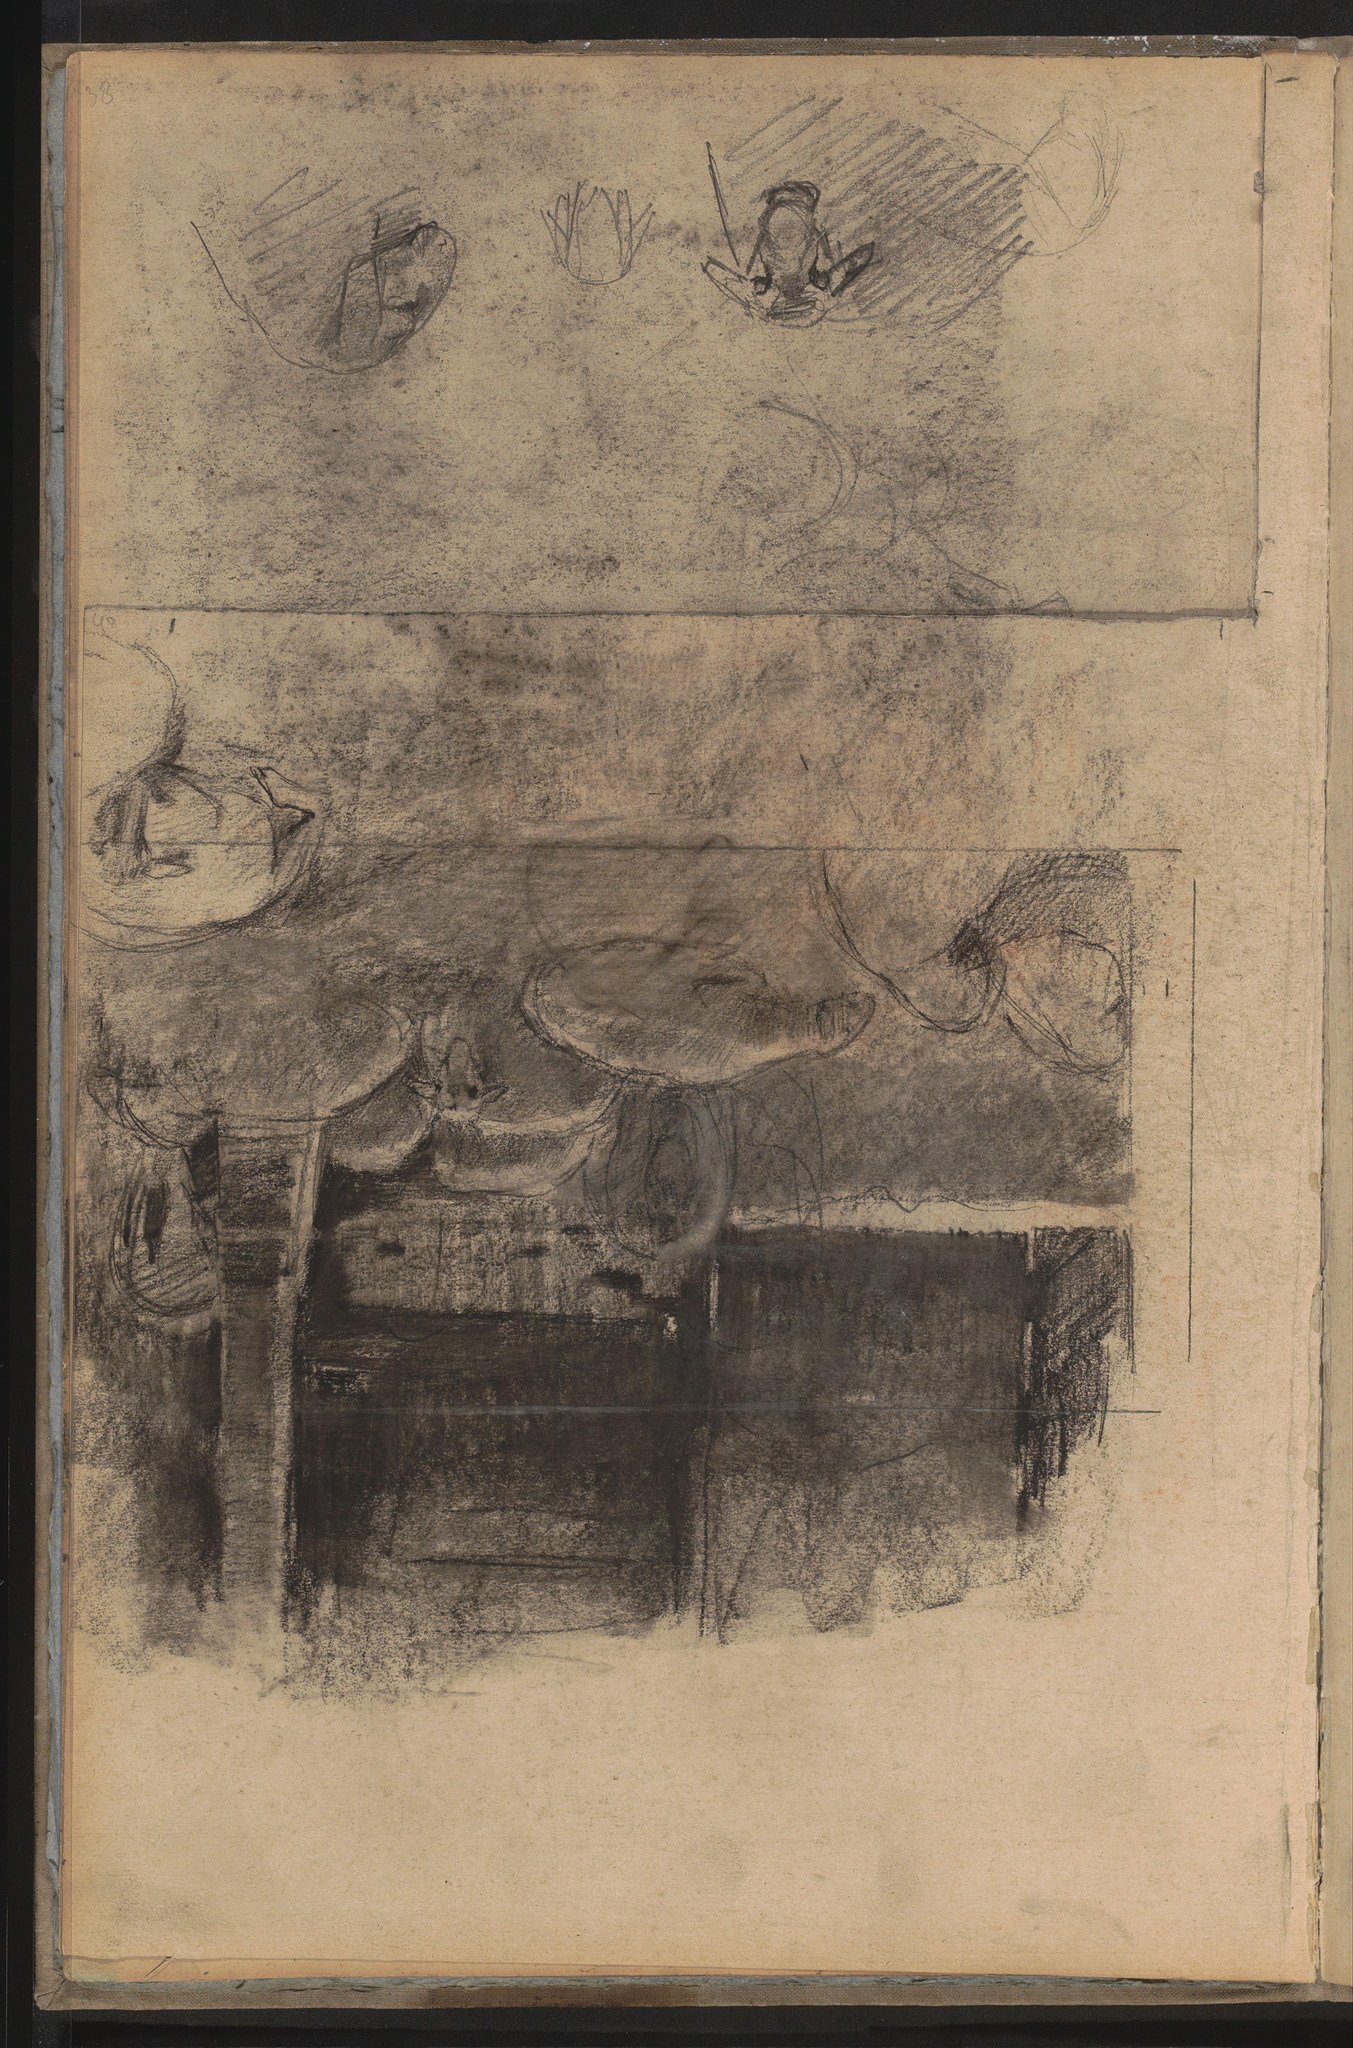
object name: sketchbook leaf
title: Schaapskooi met schapen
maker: willem witsen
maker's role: draughtsman, painter, print maker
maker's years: 1860-1923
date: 1884-1887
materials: chalk, paper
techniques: stumping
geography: ewijkshoeve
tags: sheep, stall, stable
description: Pagina 40 uit een schetsboek met 45 bladen vervaardigd rond de Ewijkshoeve.